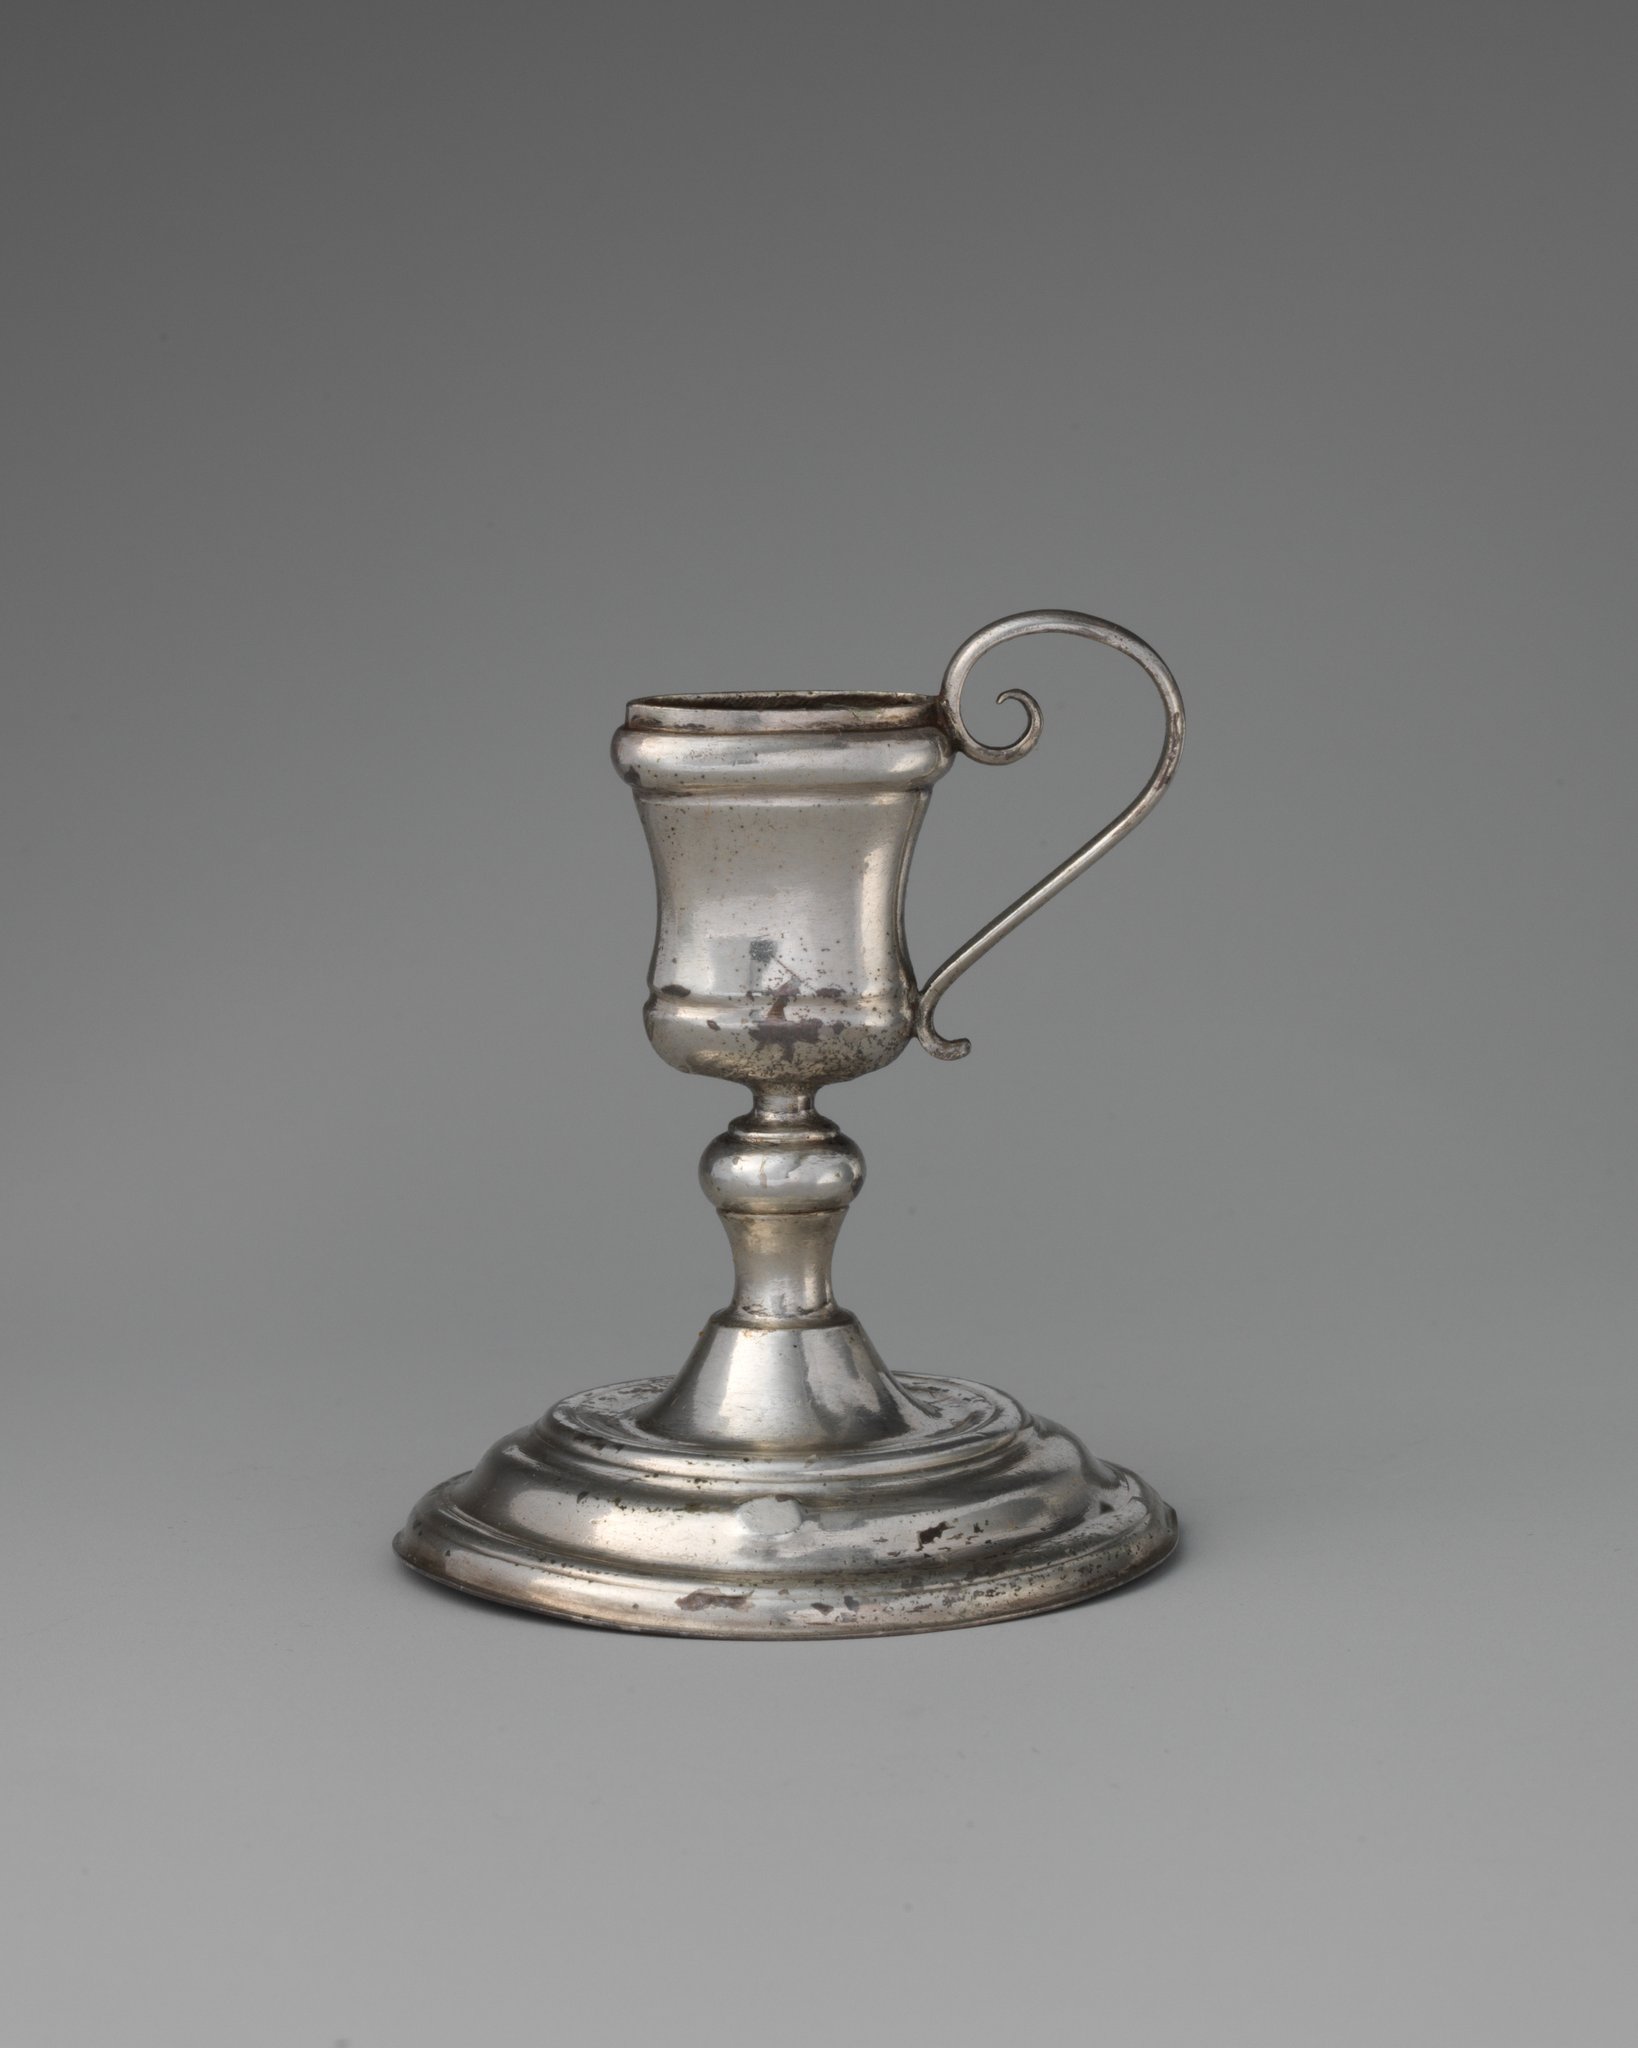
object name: snuffer stand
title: Miniature snuffers stand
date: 1667-1733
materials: silver